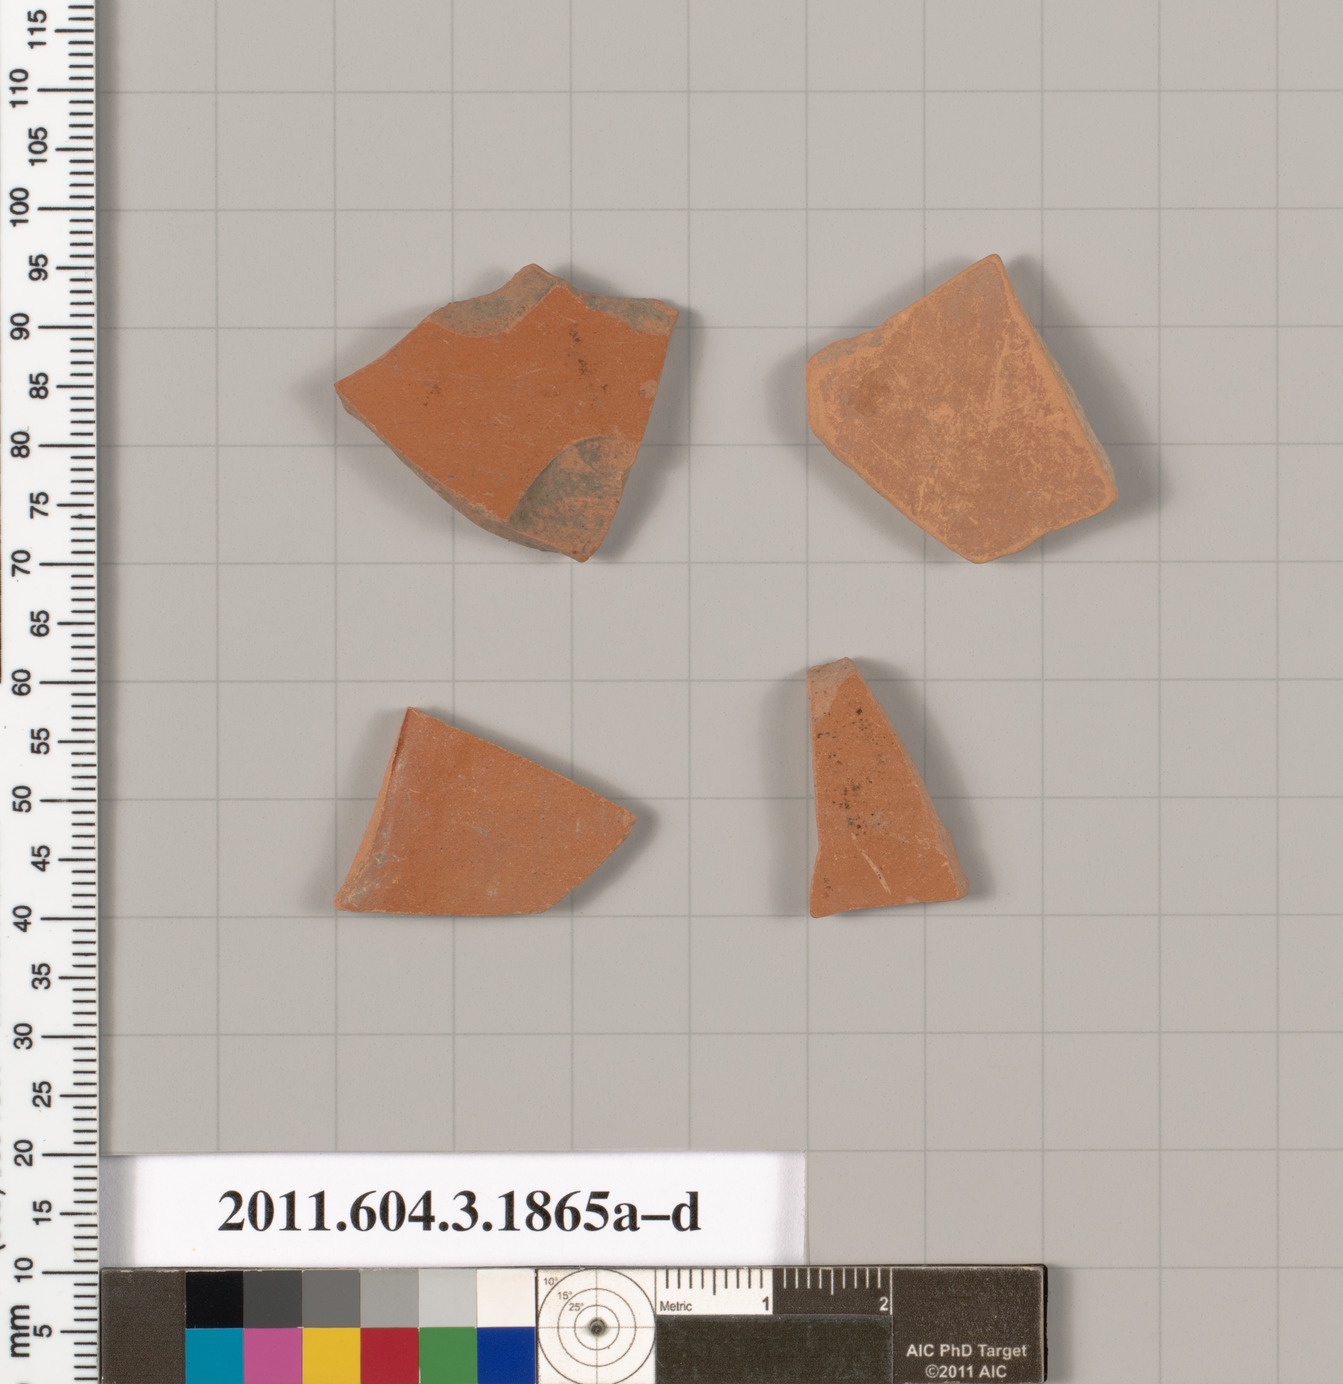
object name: kylix fragment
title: Terracotta fragments of kylikes: Band or lip cups (drinking cups)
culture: greek, attic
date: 560-525 BCE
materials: terracotta